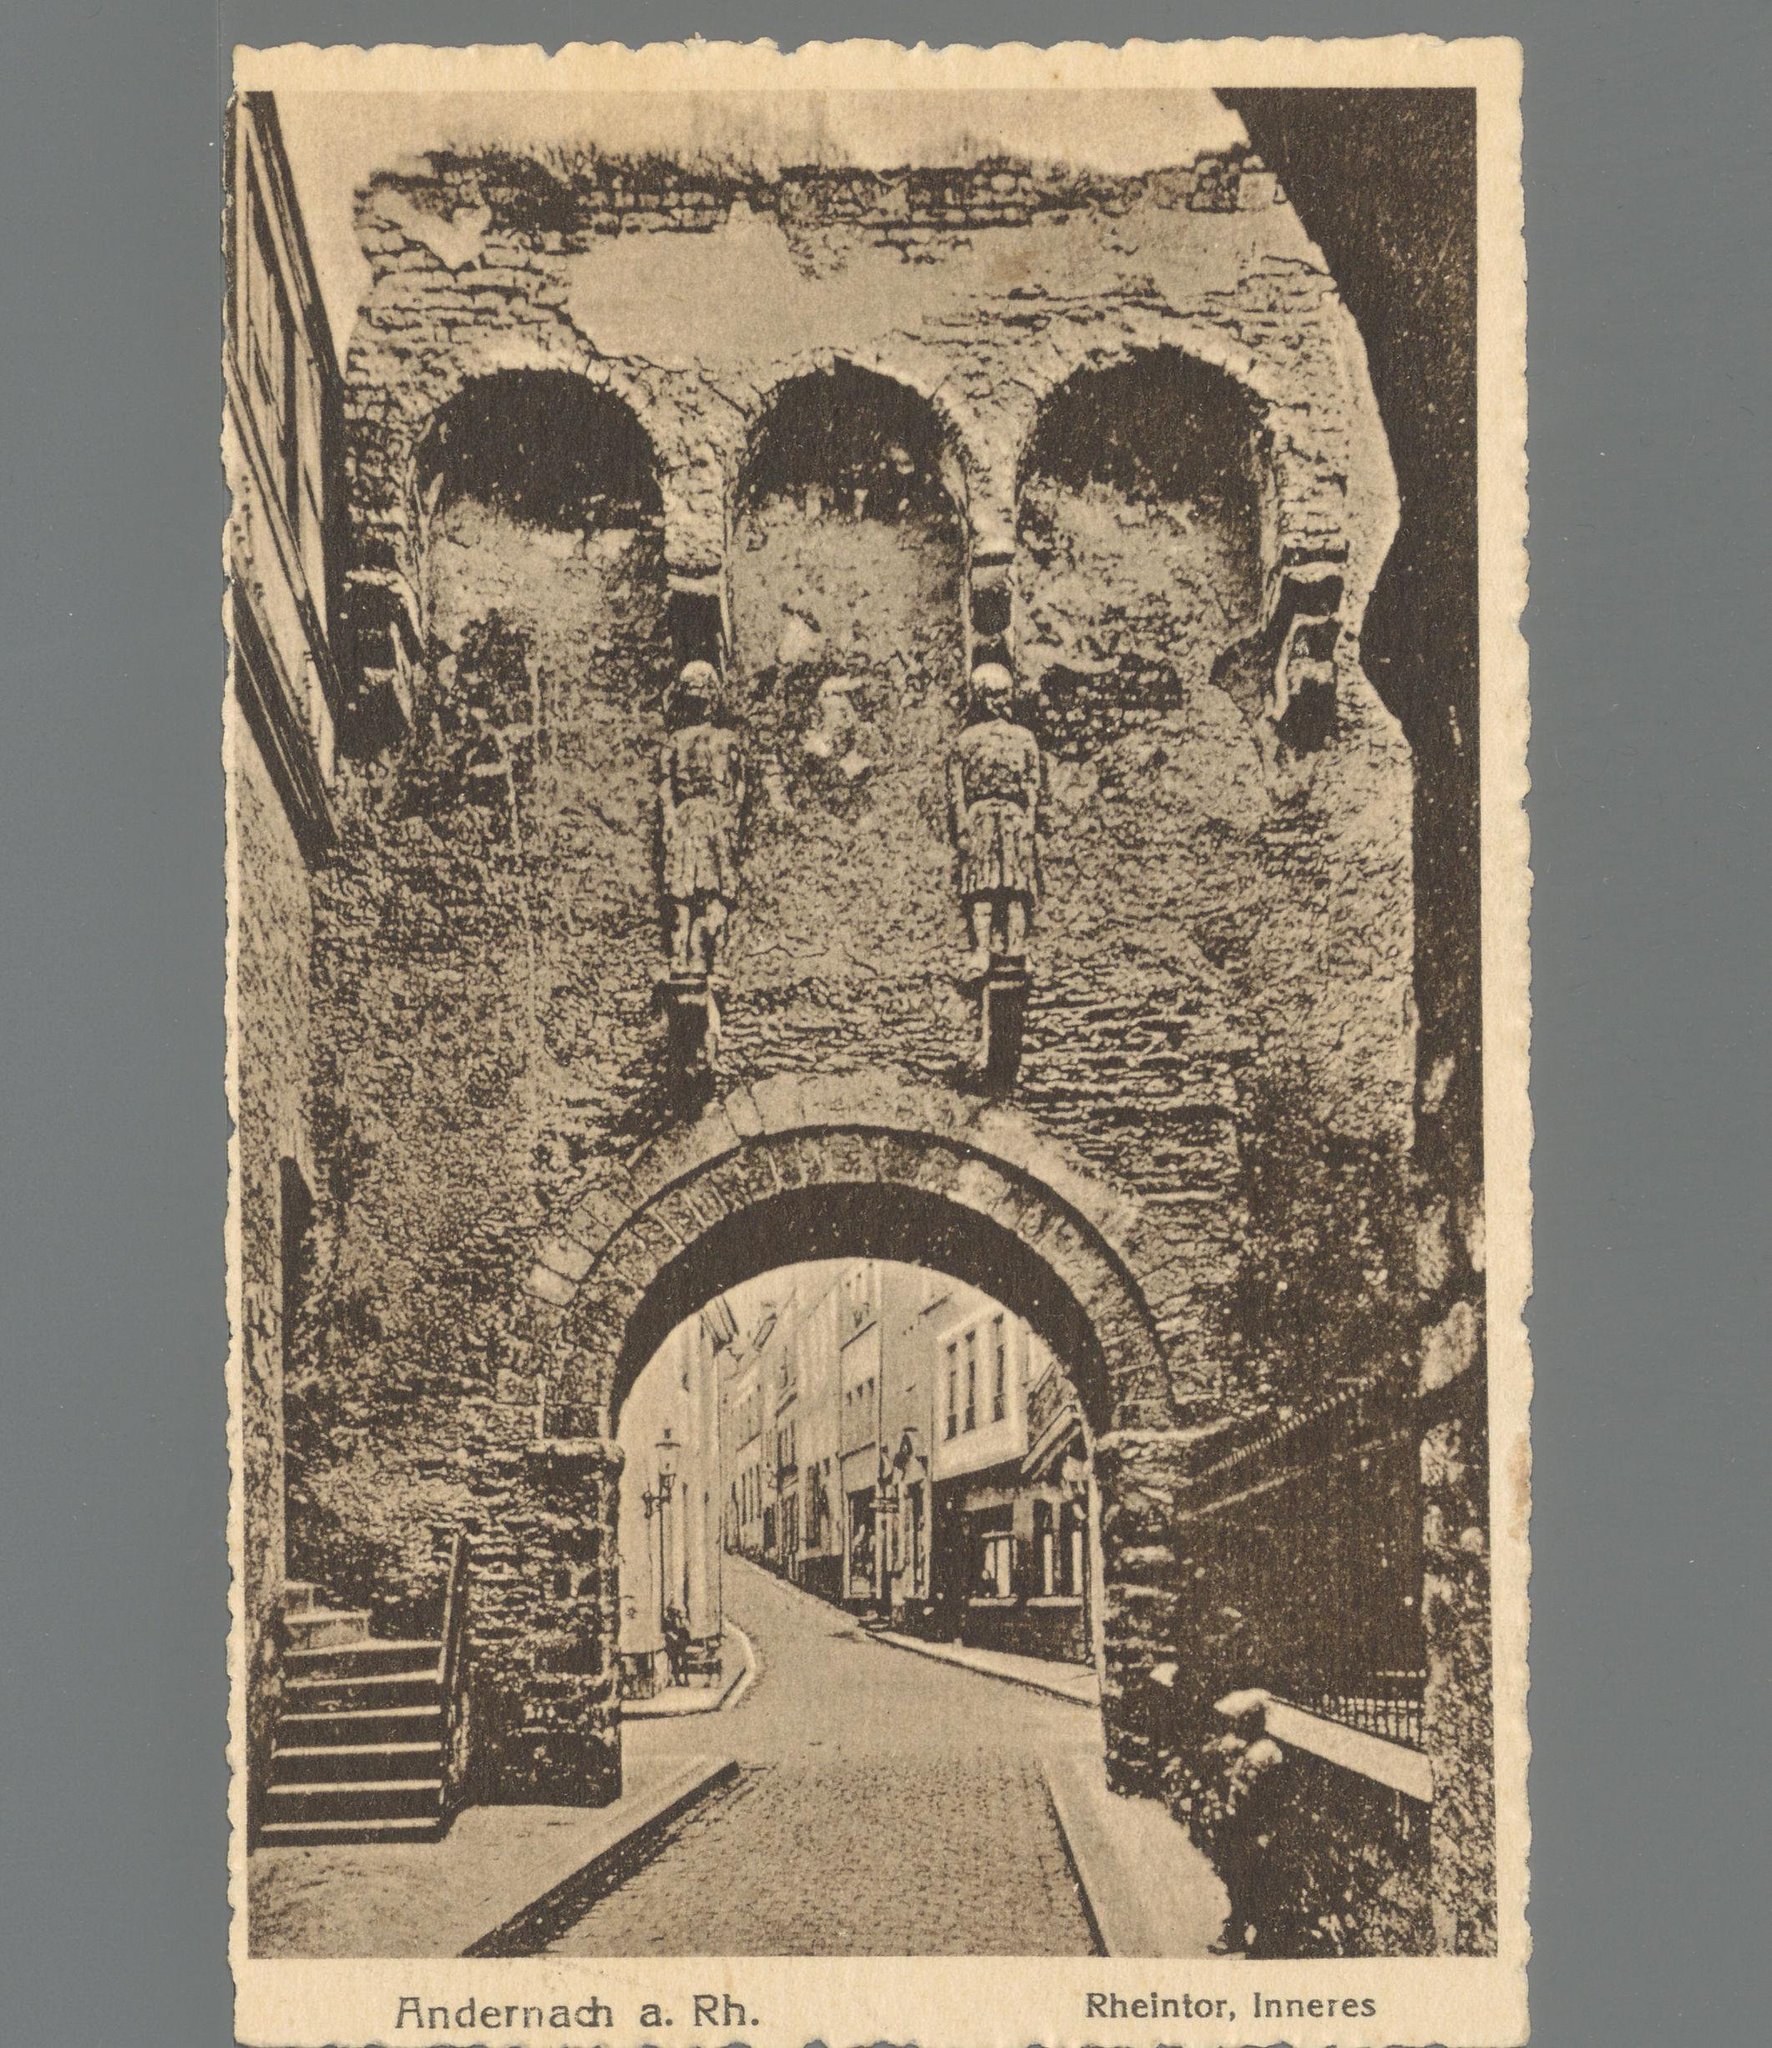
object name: ansichtkaart, prentbriefkaart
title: Andernach a. Rh. Rheintor, Inneres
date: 1905-1930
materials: cardboard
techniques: photograph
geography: andernach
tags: towers ~ fortified city